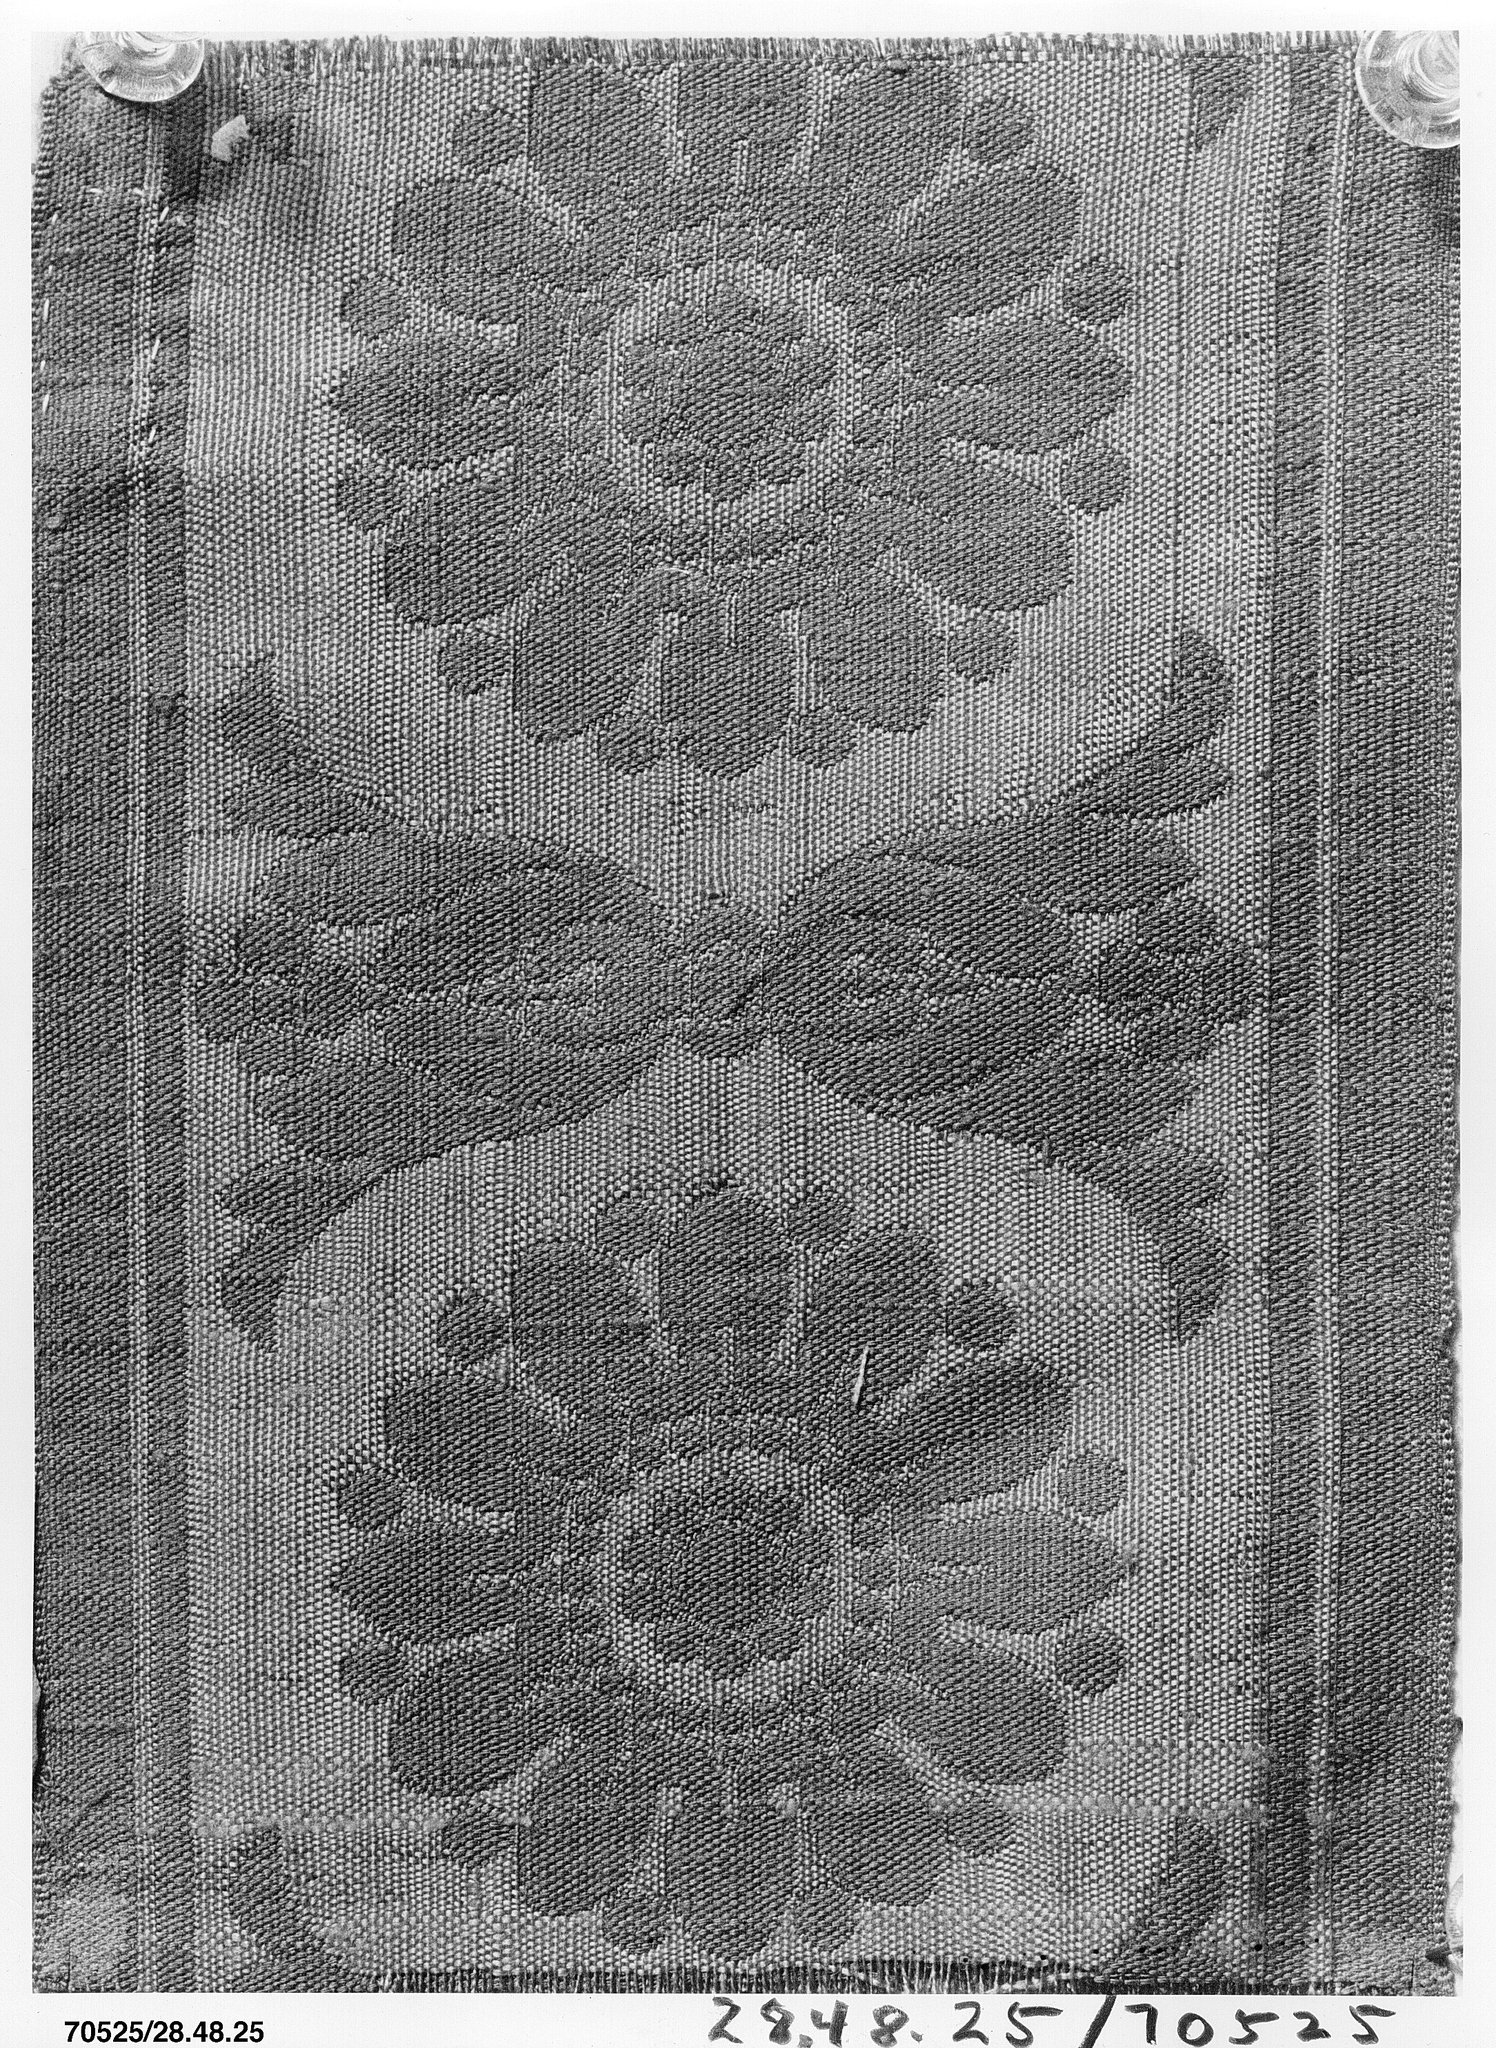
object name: piece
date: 1801-1850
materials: silk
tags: flowers